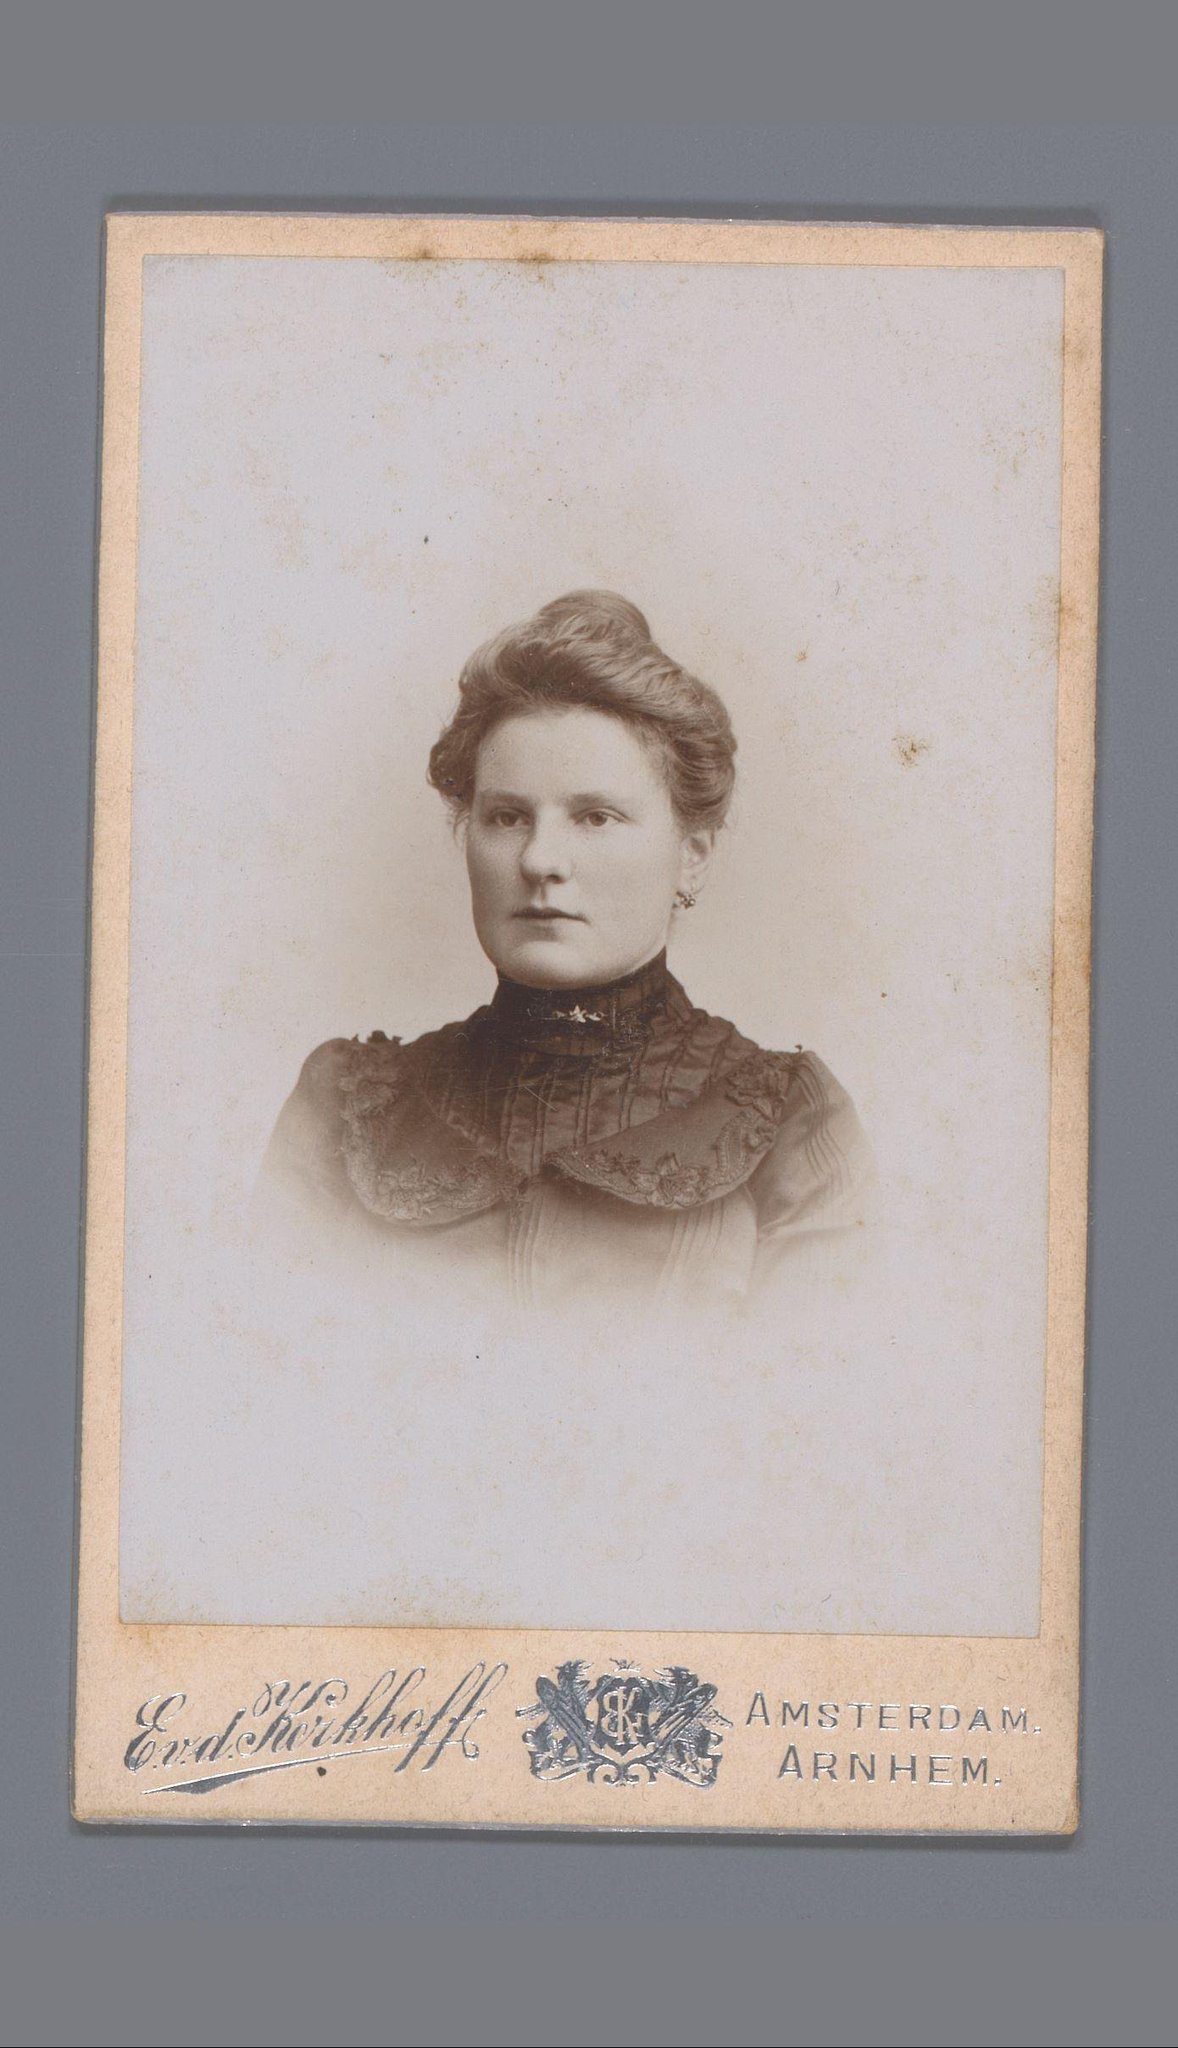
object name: photograph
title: Portret van een onbekende vrouw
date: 1902-1908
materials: cardboard, photographic support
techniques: collodion silver print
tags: historical persons - bb - woman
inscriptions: inscription: ‘ATELIER/ E. v.d. KERKHOFF/ Amsterdam./ Keizersgracht 455./ Hoek Leidschestraat./ Lift bij den Portier./ Vergrootingen naar dit en elk ander Portret/ worden prachtig uitgevoerd./ De Plaat blijft voor Nabestelling bewaard.’